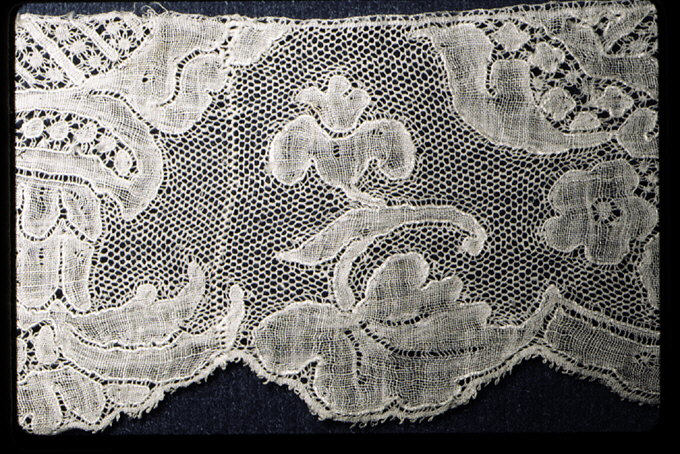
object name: edging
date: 1701-1800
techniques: lace